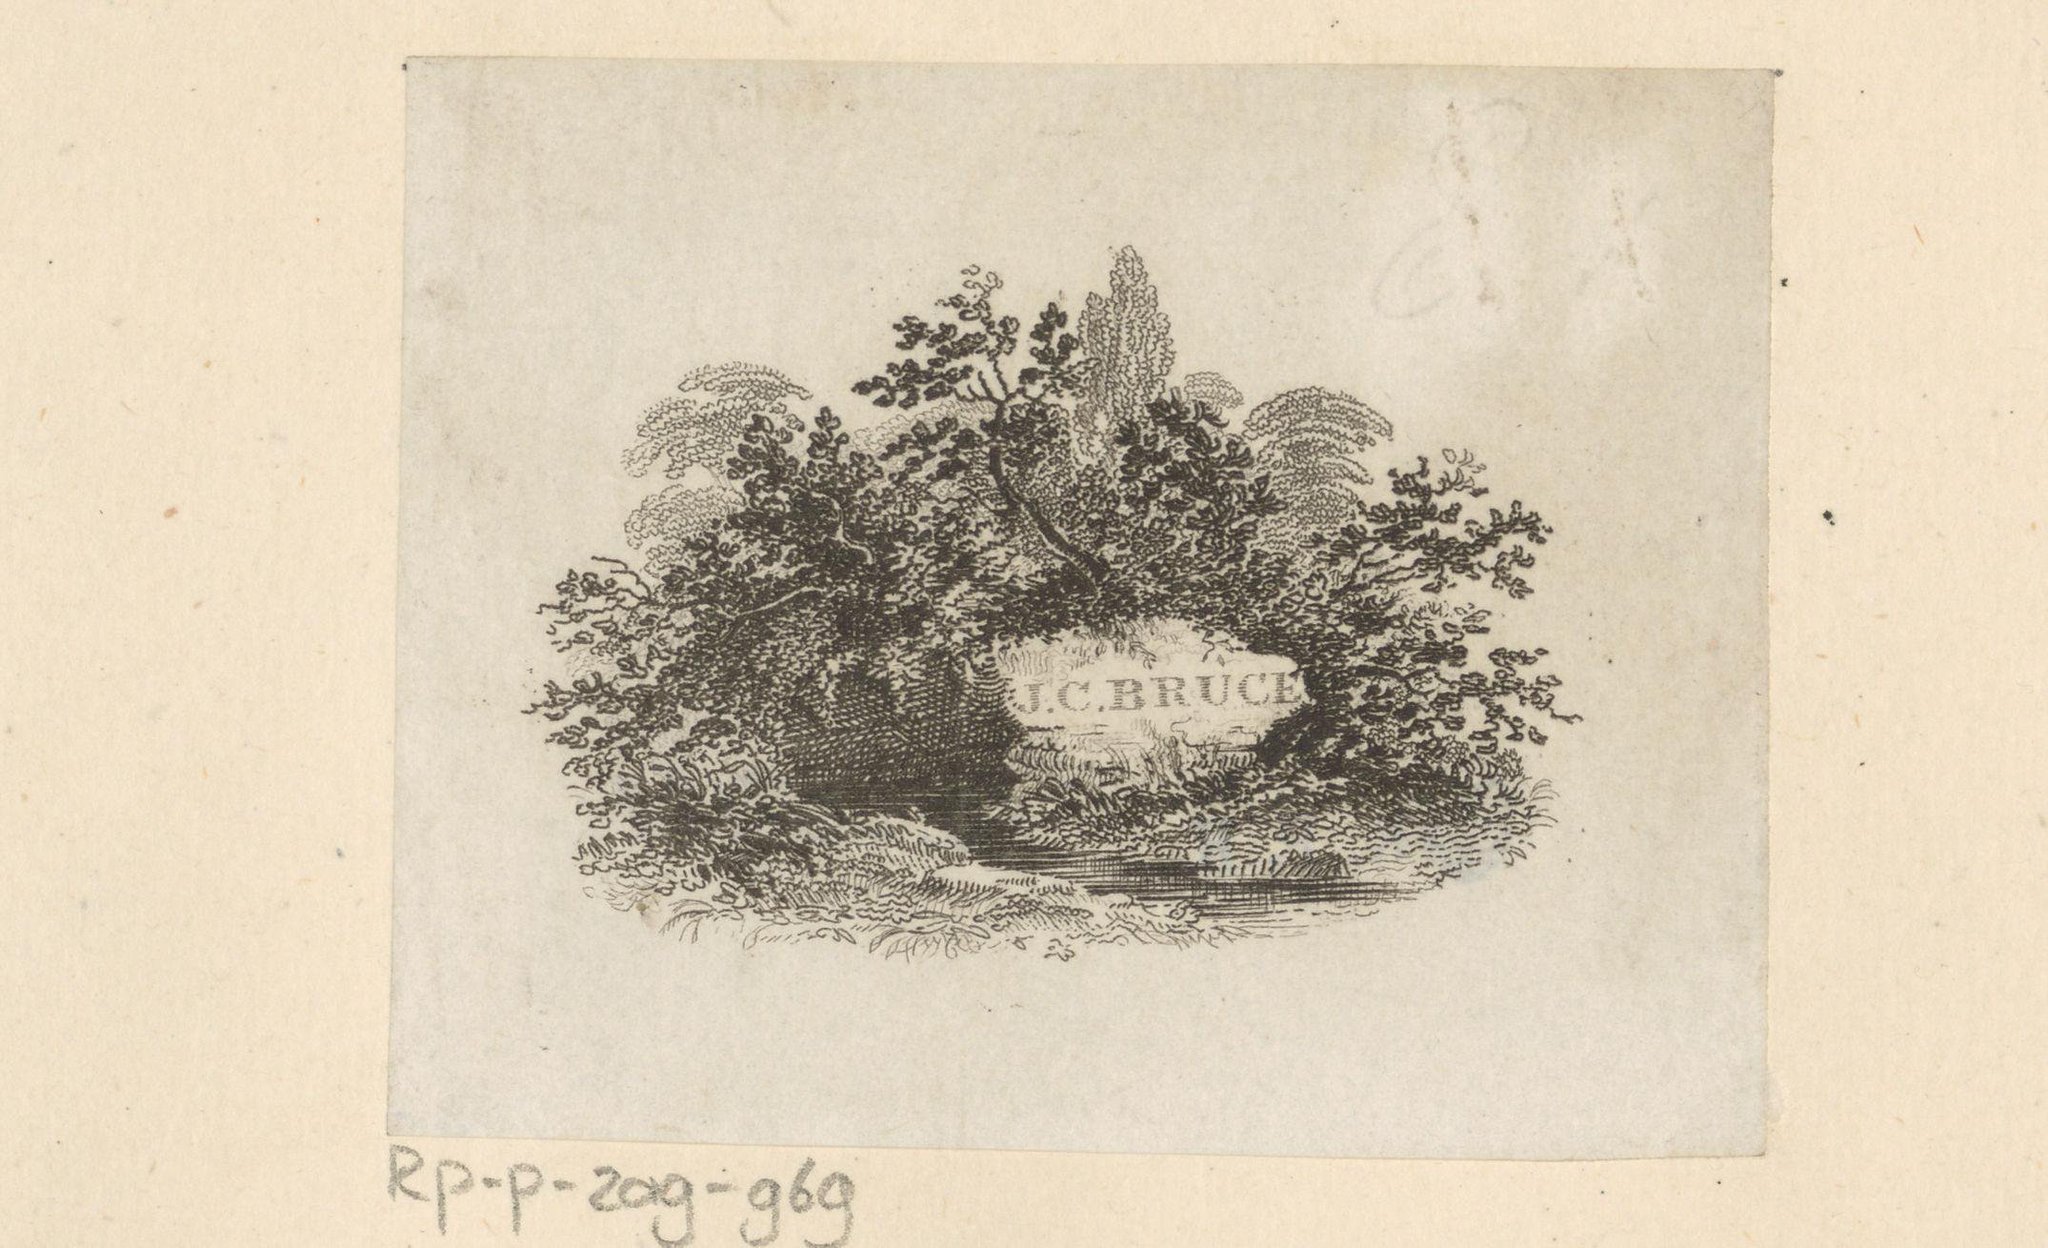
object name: bookplate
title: Ex libris van J.C. Bruce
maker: thomas bewick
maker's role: draughtsman, painter, print maker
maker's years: 1753-1828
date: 1790-1828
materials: paper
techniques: etching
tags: shrubs